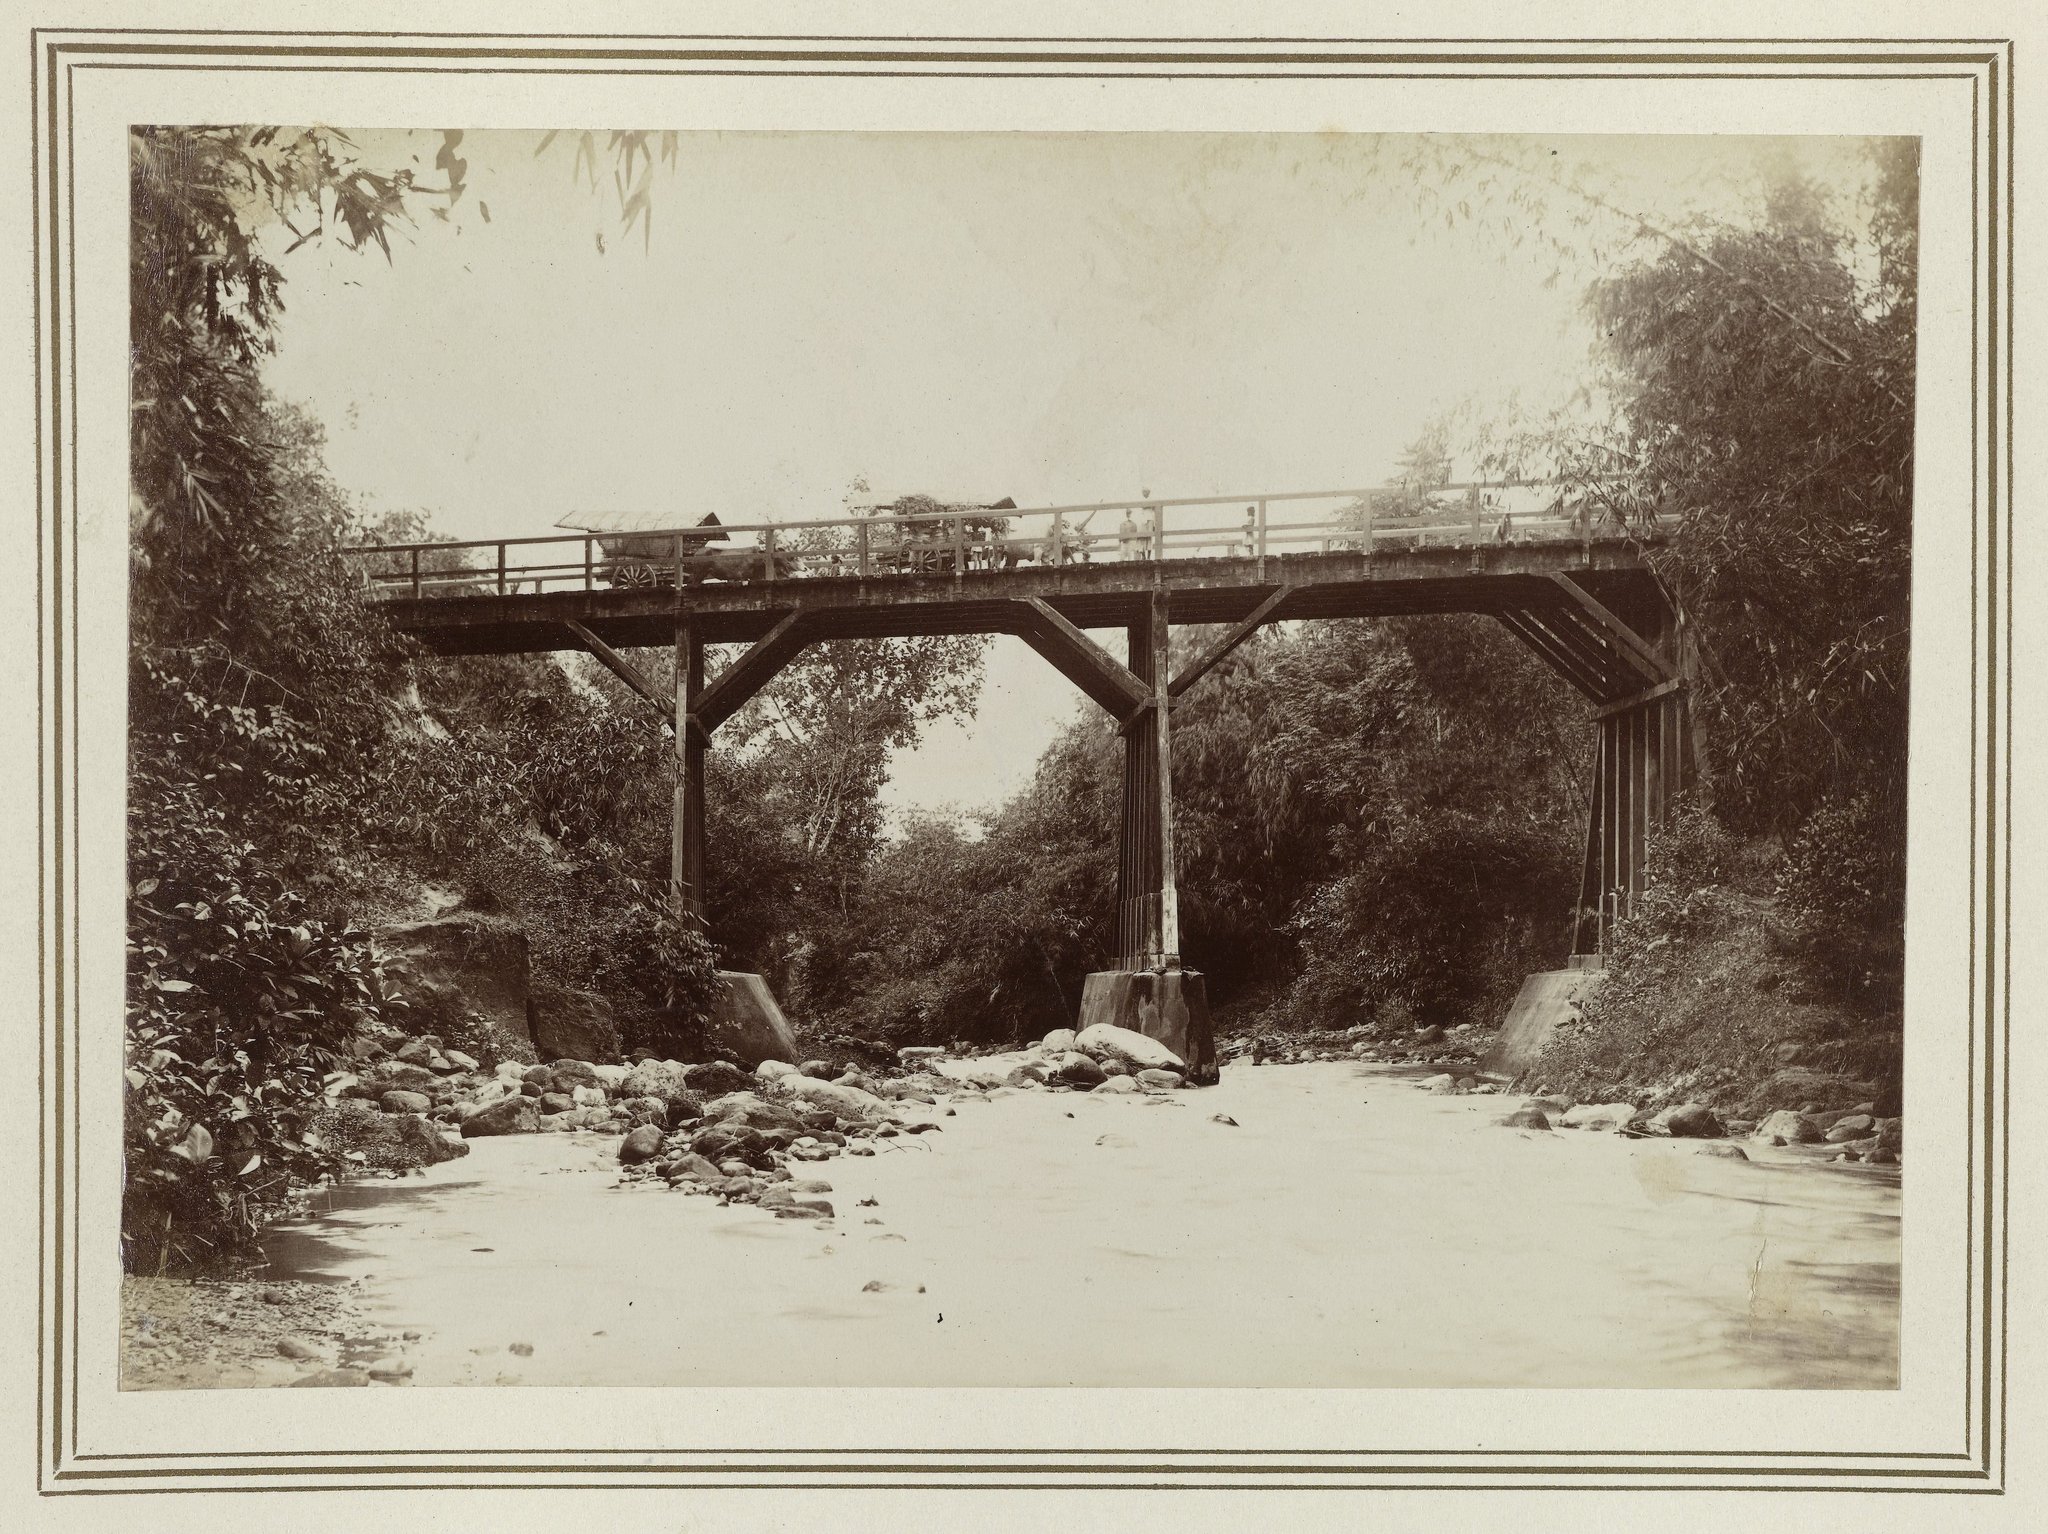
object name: photograph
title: Brug over een rivier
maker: kassian céphas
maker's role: fotograaf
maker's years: 1845-1912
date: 1886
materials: photographic support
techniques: albumen print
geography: jogjakarta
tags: the hague, bridge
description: Landschap met een brug over een rivier. Onderdeel van het fotoalbum aangeboden aan J.M. Pijnacker Hordijk bij zijn vertrek uit Jogyakarta in 1886.